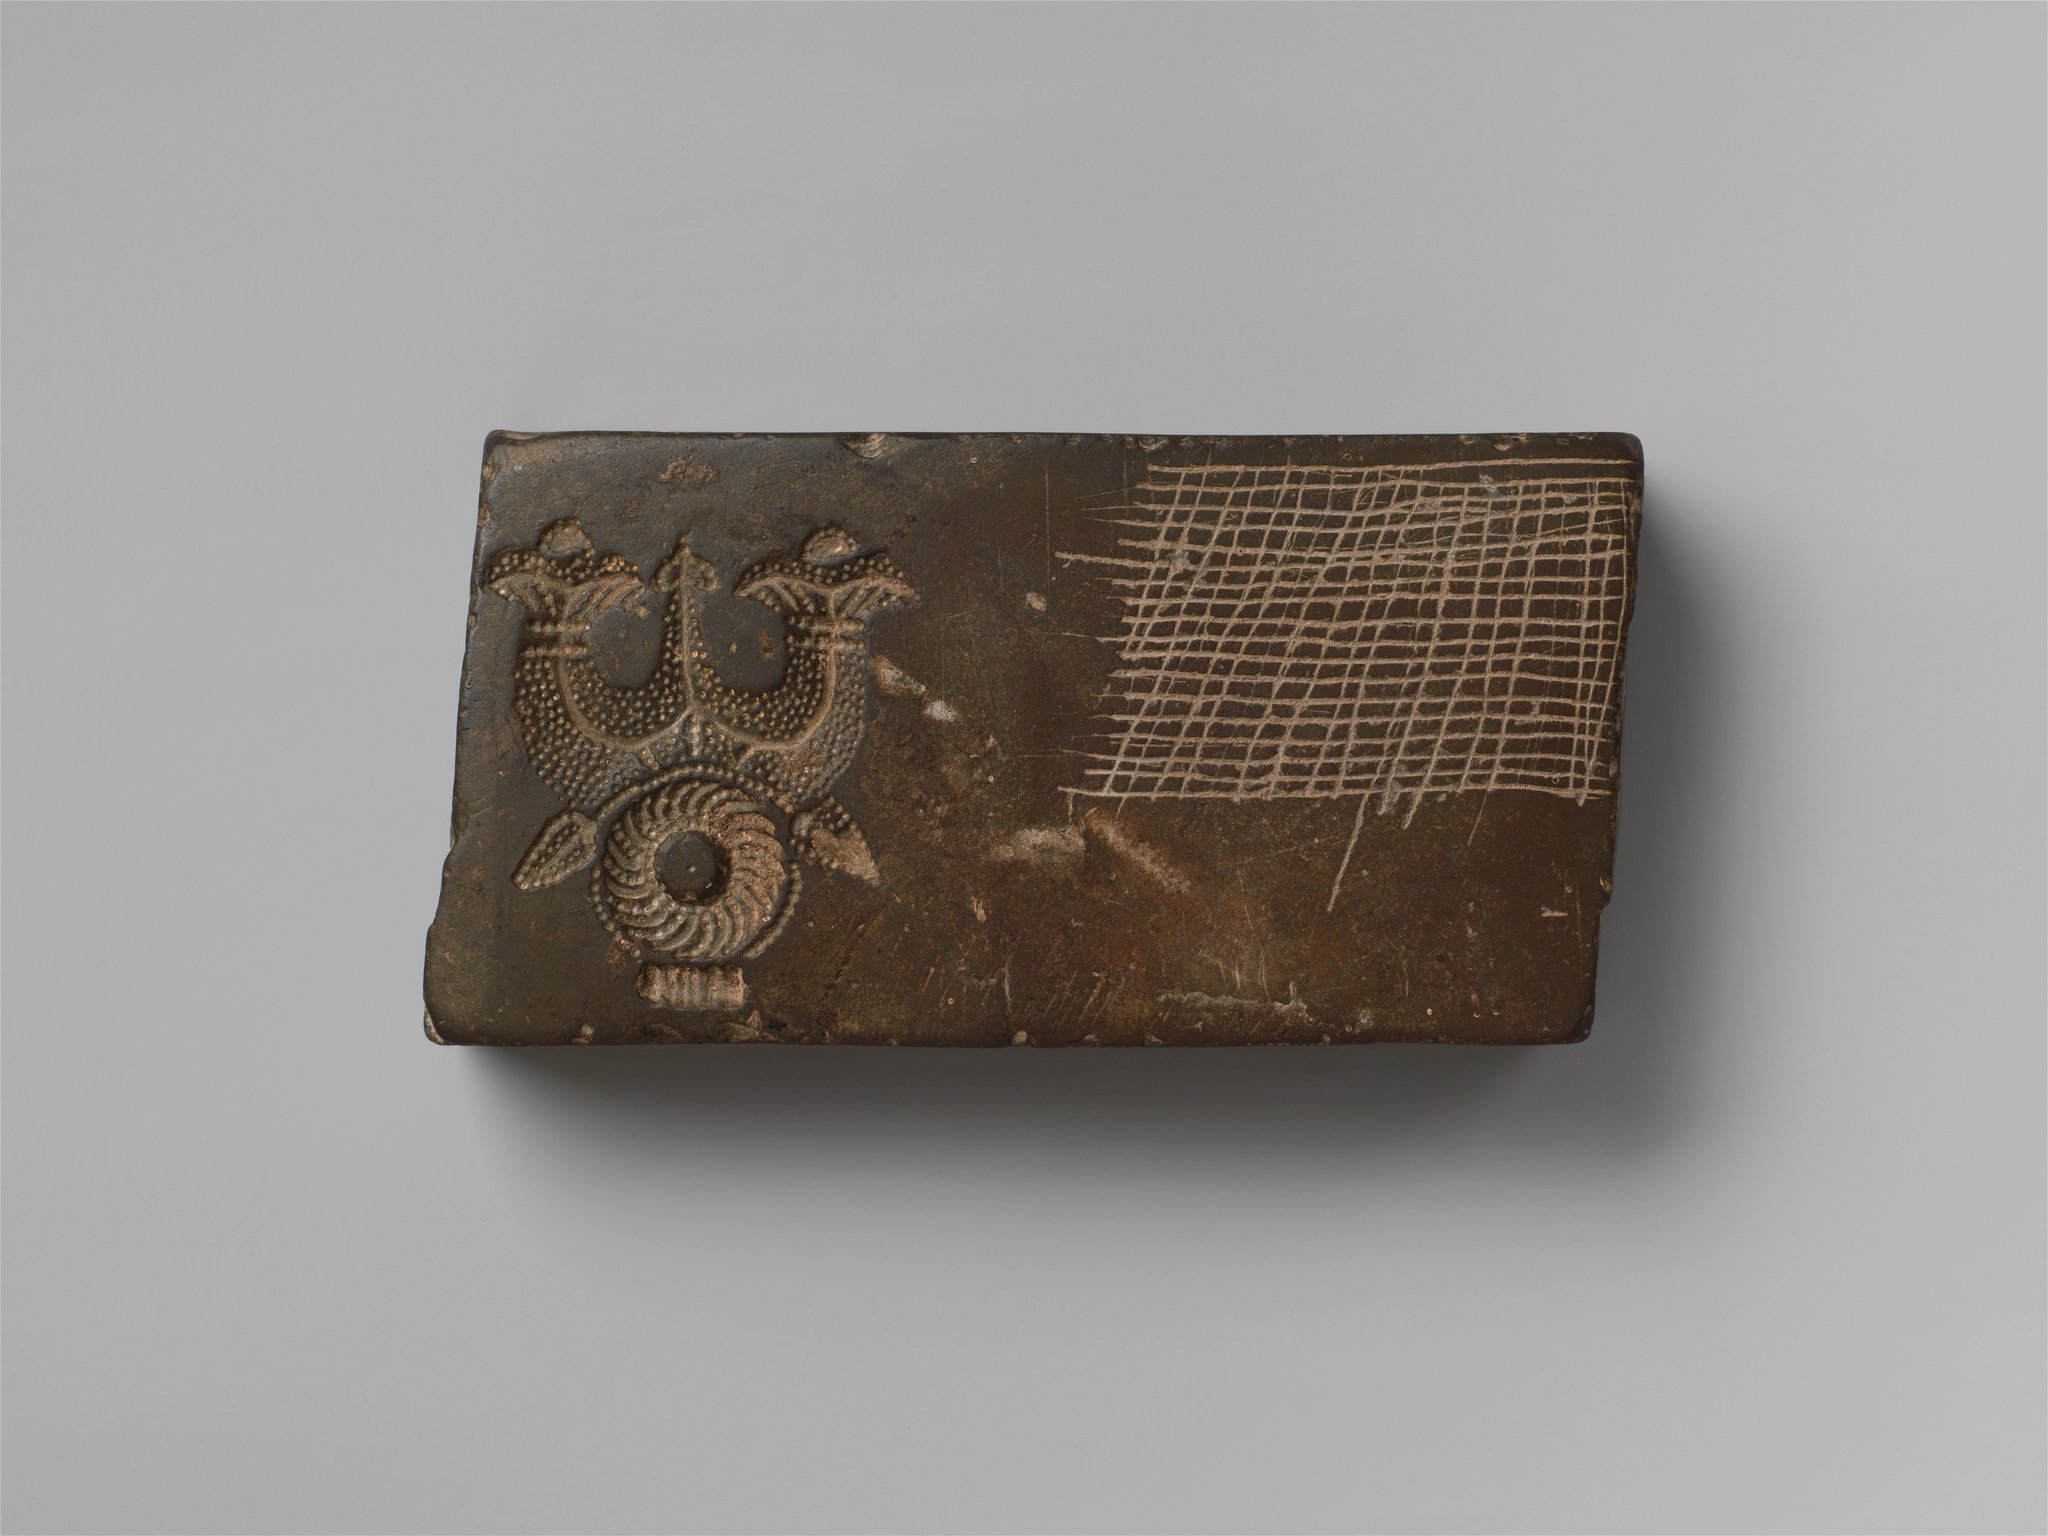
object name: jewelry mold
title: Jewelry Mold with Figures in a Temple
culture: indian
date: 1-100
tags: satavahana